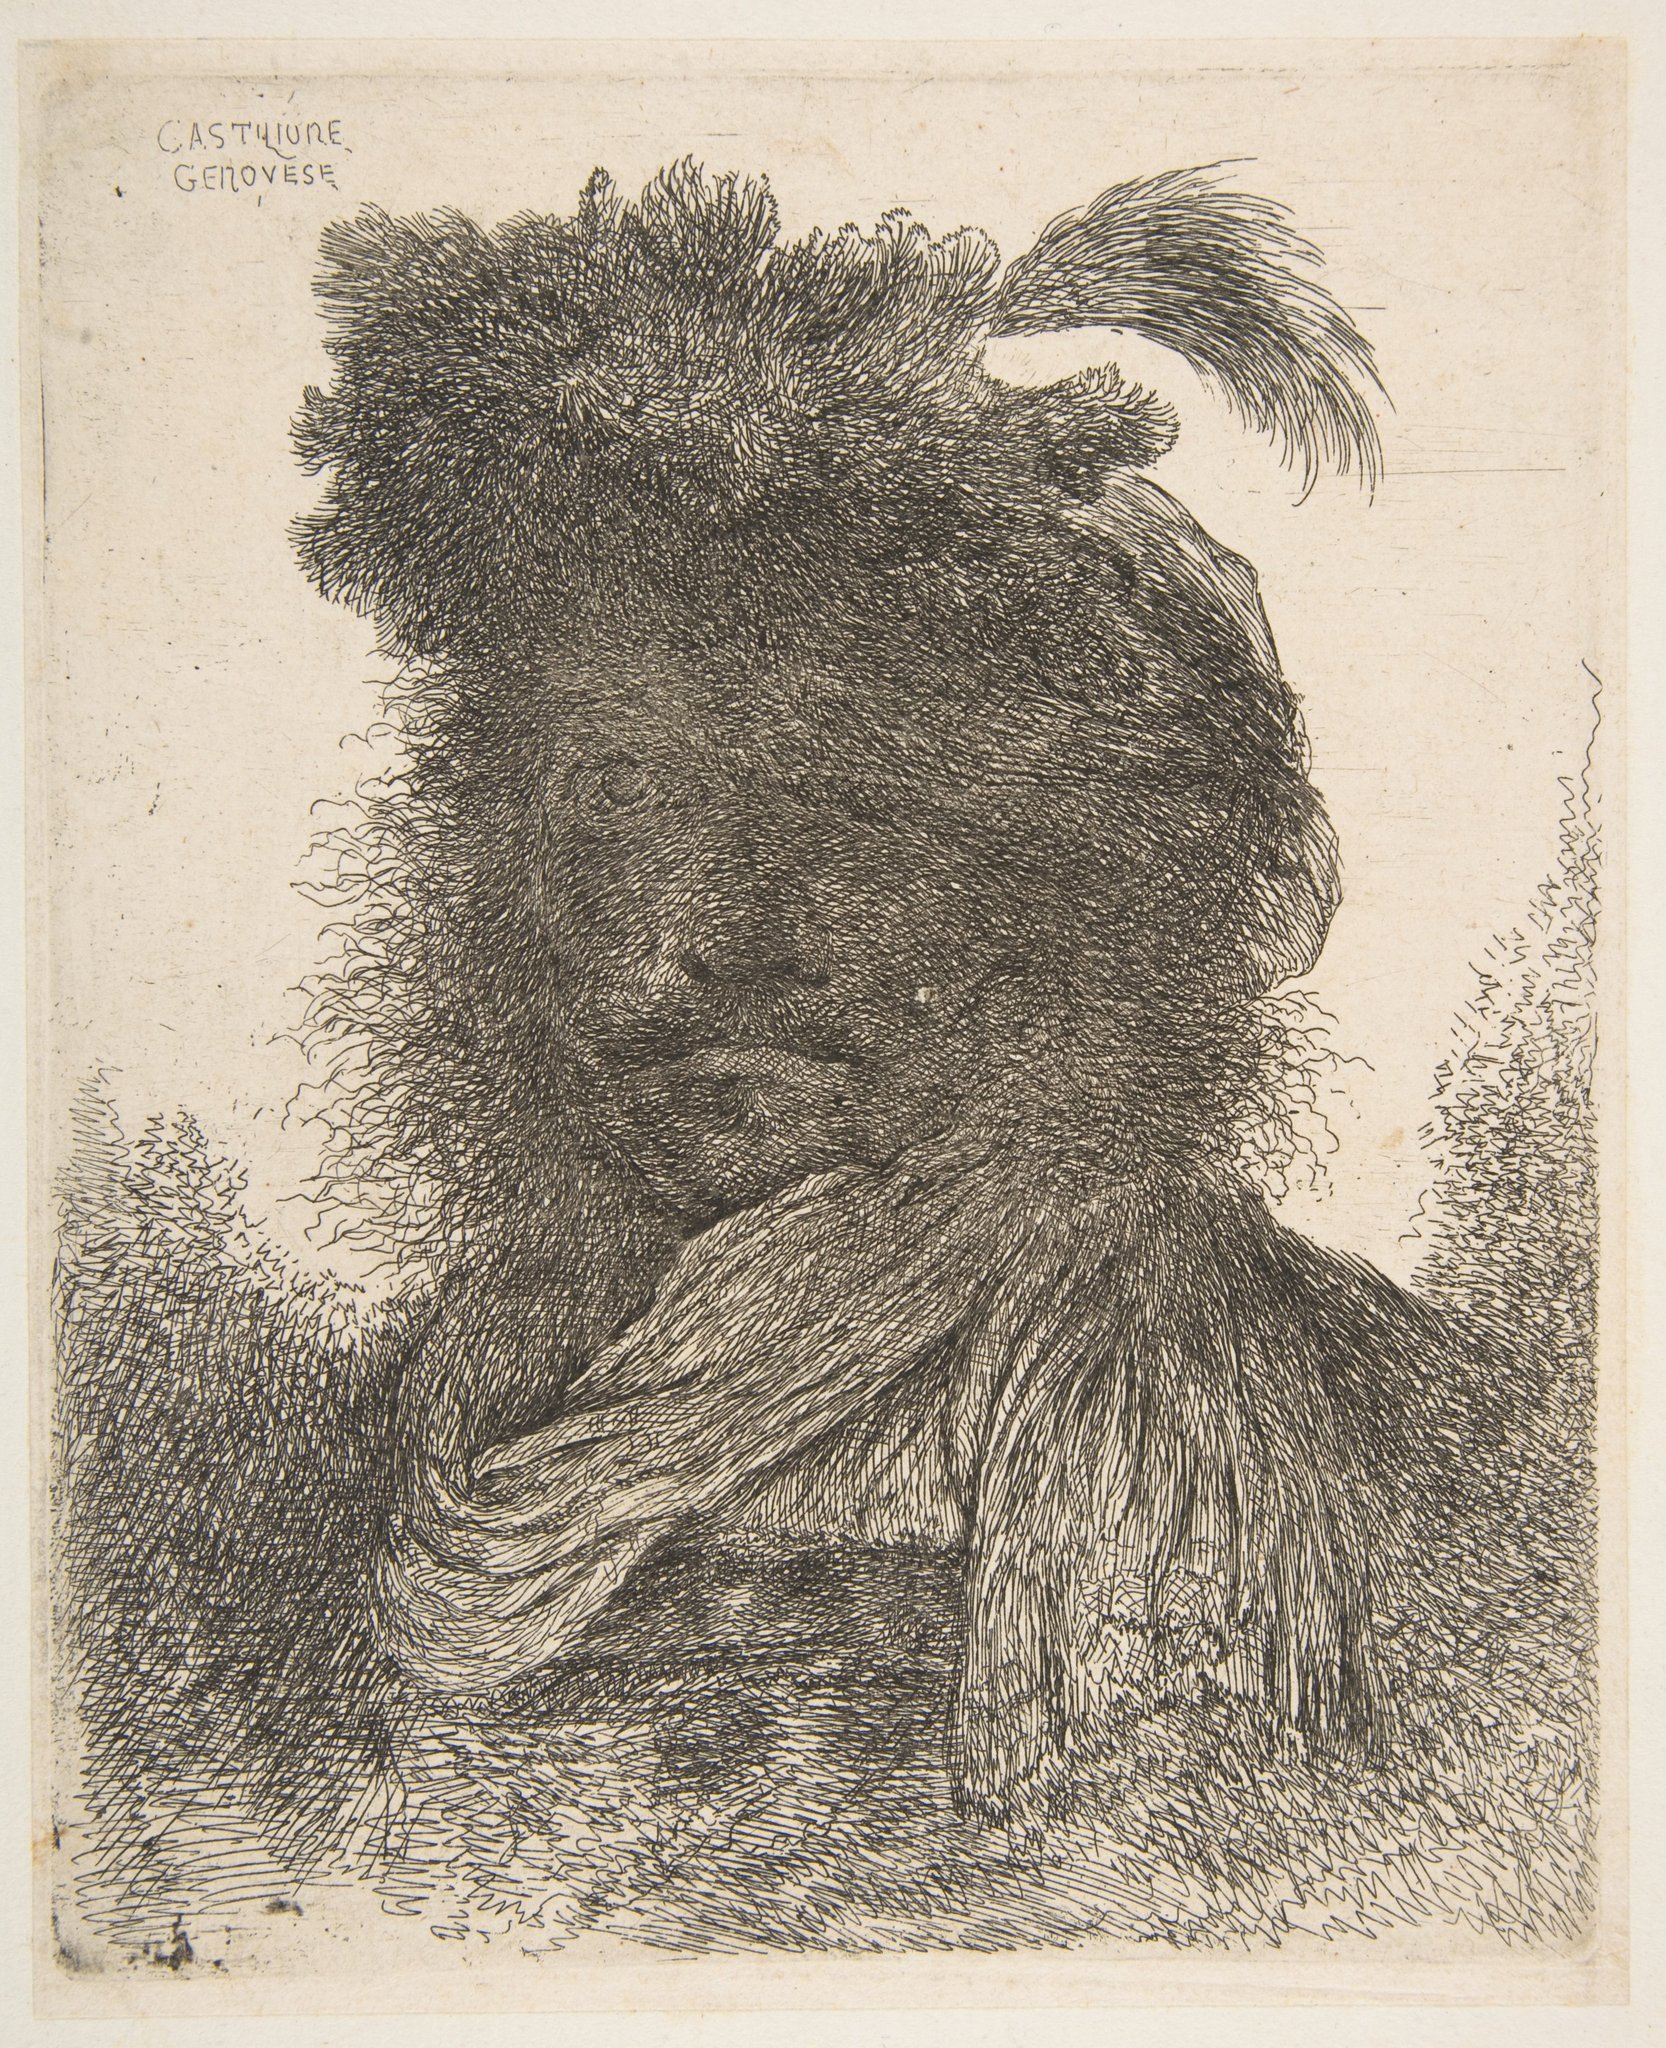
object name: print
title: Head of a man in shadow turned slightly to the left, from "Large Oriental Heads"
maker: giovanni benedetto castiglione (il grechetto)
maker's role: artist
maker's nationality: italian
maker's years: 1609-1664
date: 1645-1650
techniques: etching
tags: heads,men,portraits